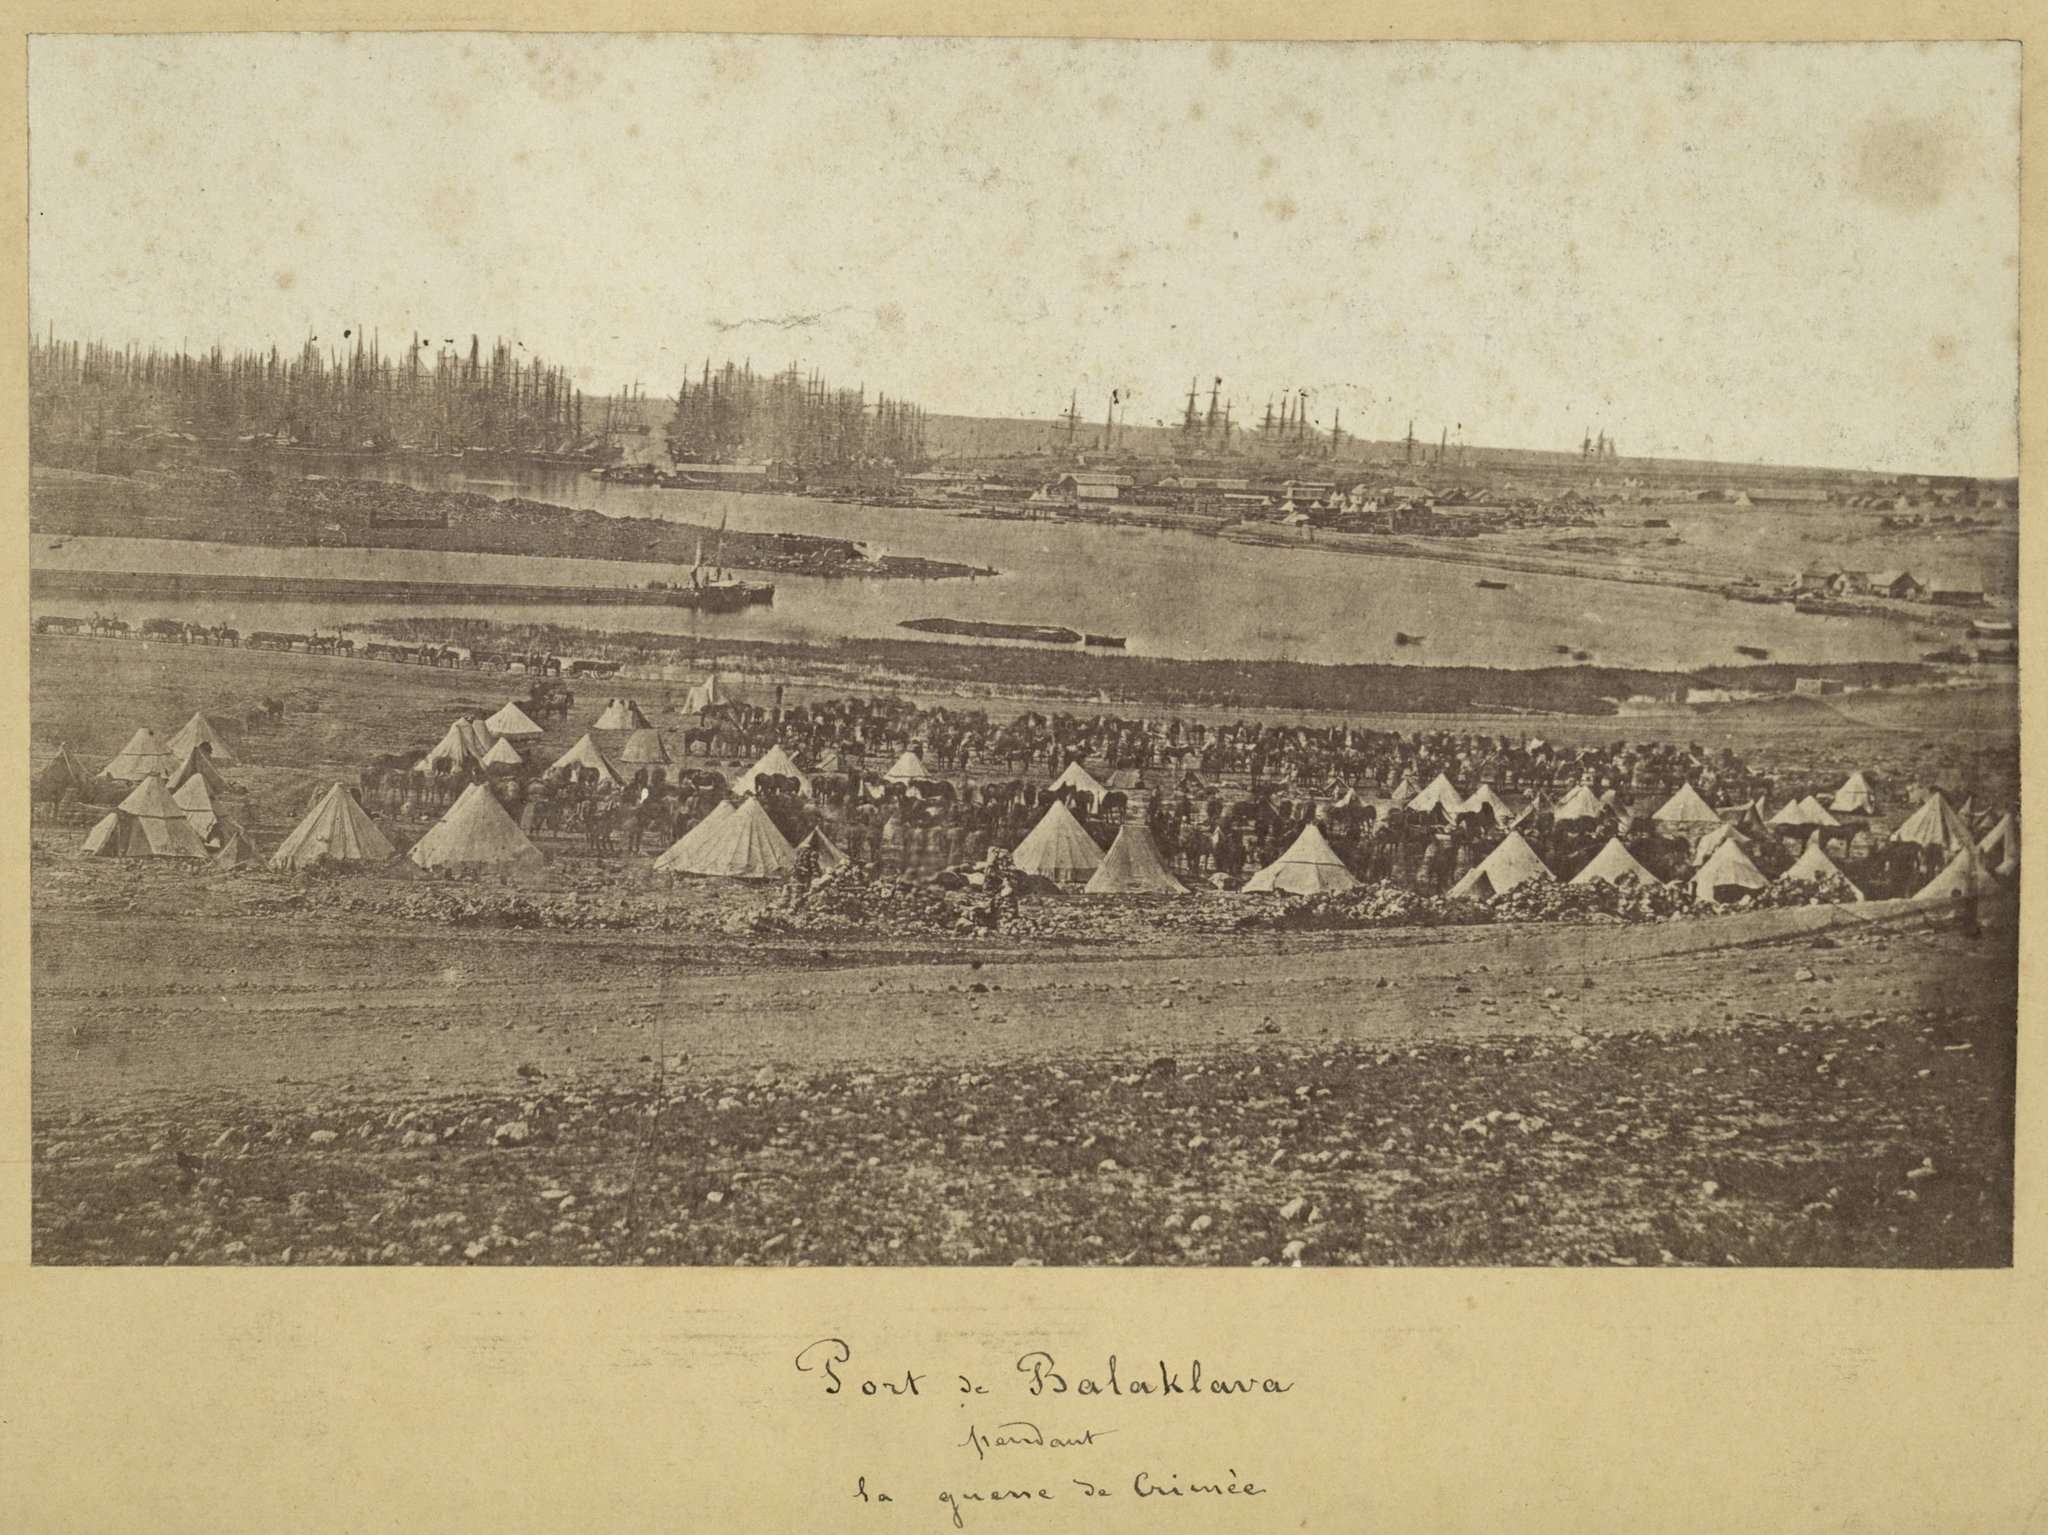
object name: photograph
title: Port de Balaklava pendant la guerre de Crimèe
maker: james robertson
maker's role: fotograaf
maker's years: 1813-1888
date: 1854-1856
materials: cardboard, photographic support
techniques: salted paper print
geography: balaklava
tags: harbour